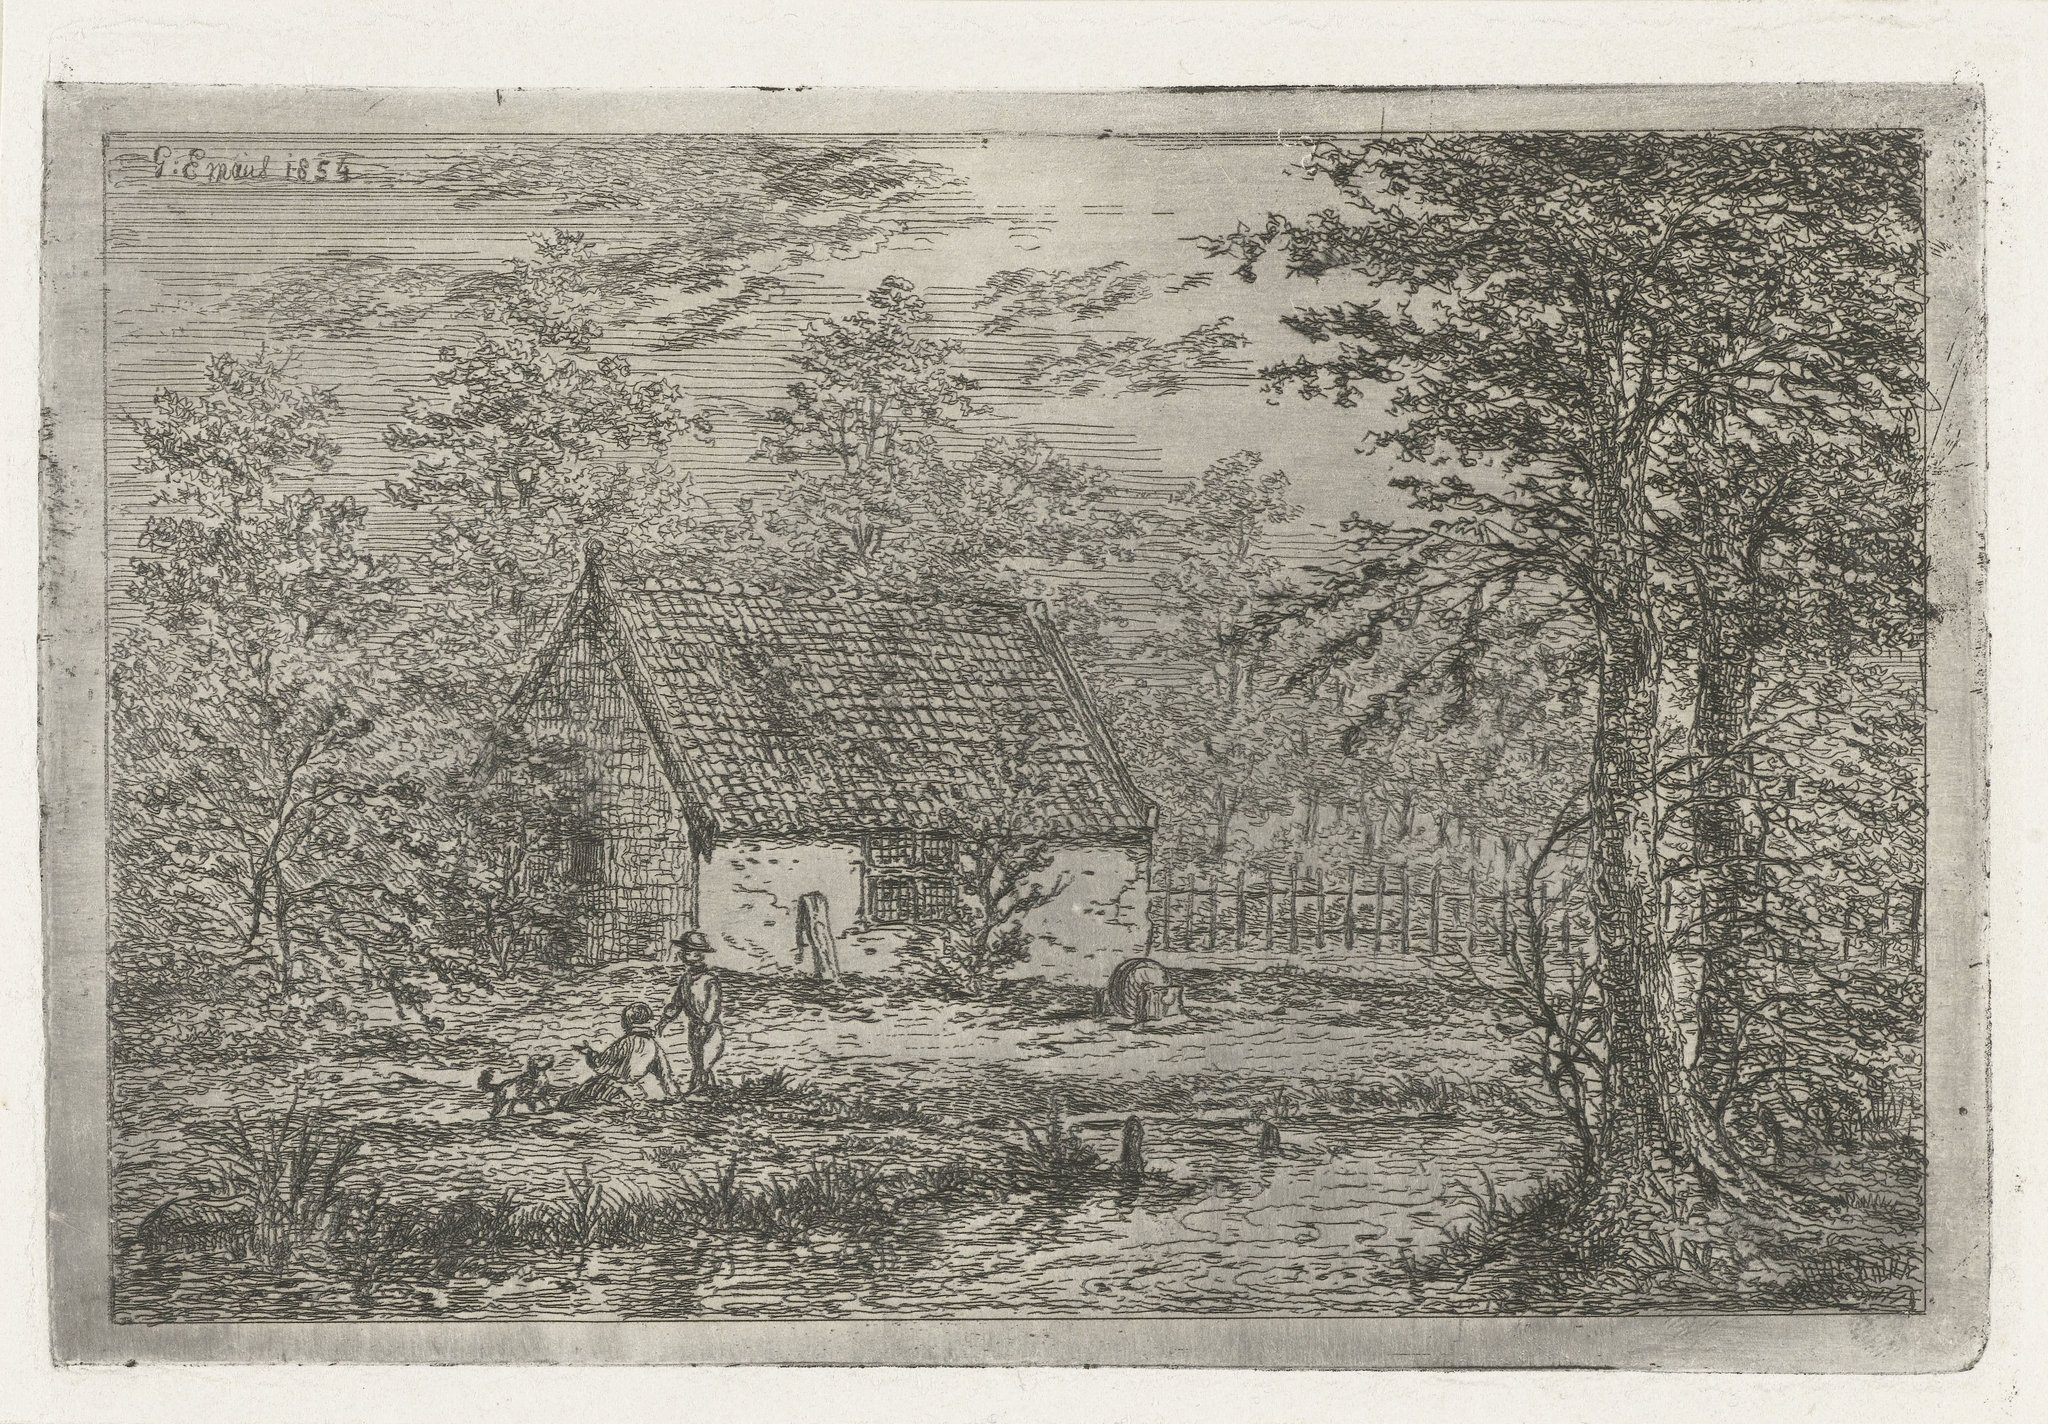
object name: print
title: De schuur van den boschwachter te 's Gravenhage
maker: gerardus emaus de micault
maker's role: draughtsman, print maker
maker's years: 1798-1863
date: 1854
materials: paper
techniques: etching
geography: netherlands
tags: farm or solitary house in landscape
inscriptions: date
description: Gezicht op een schuur tussen de bomen. Op de voorgrond een sloot met aan de oever een man en zittende vrouw met hond.